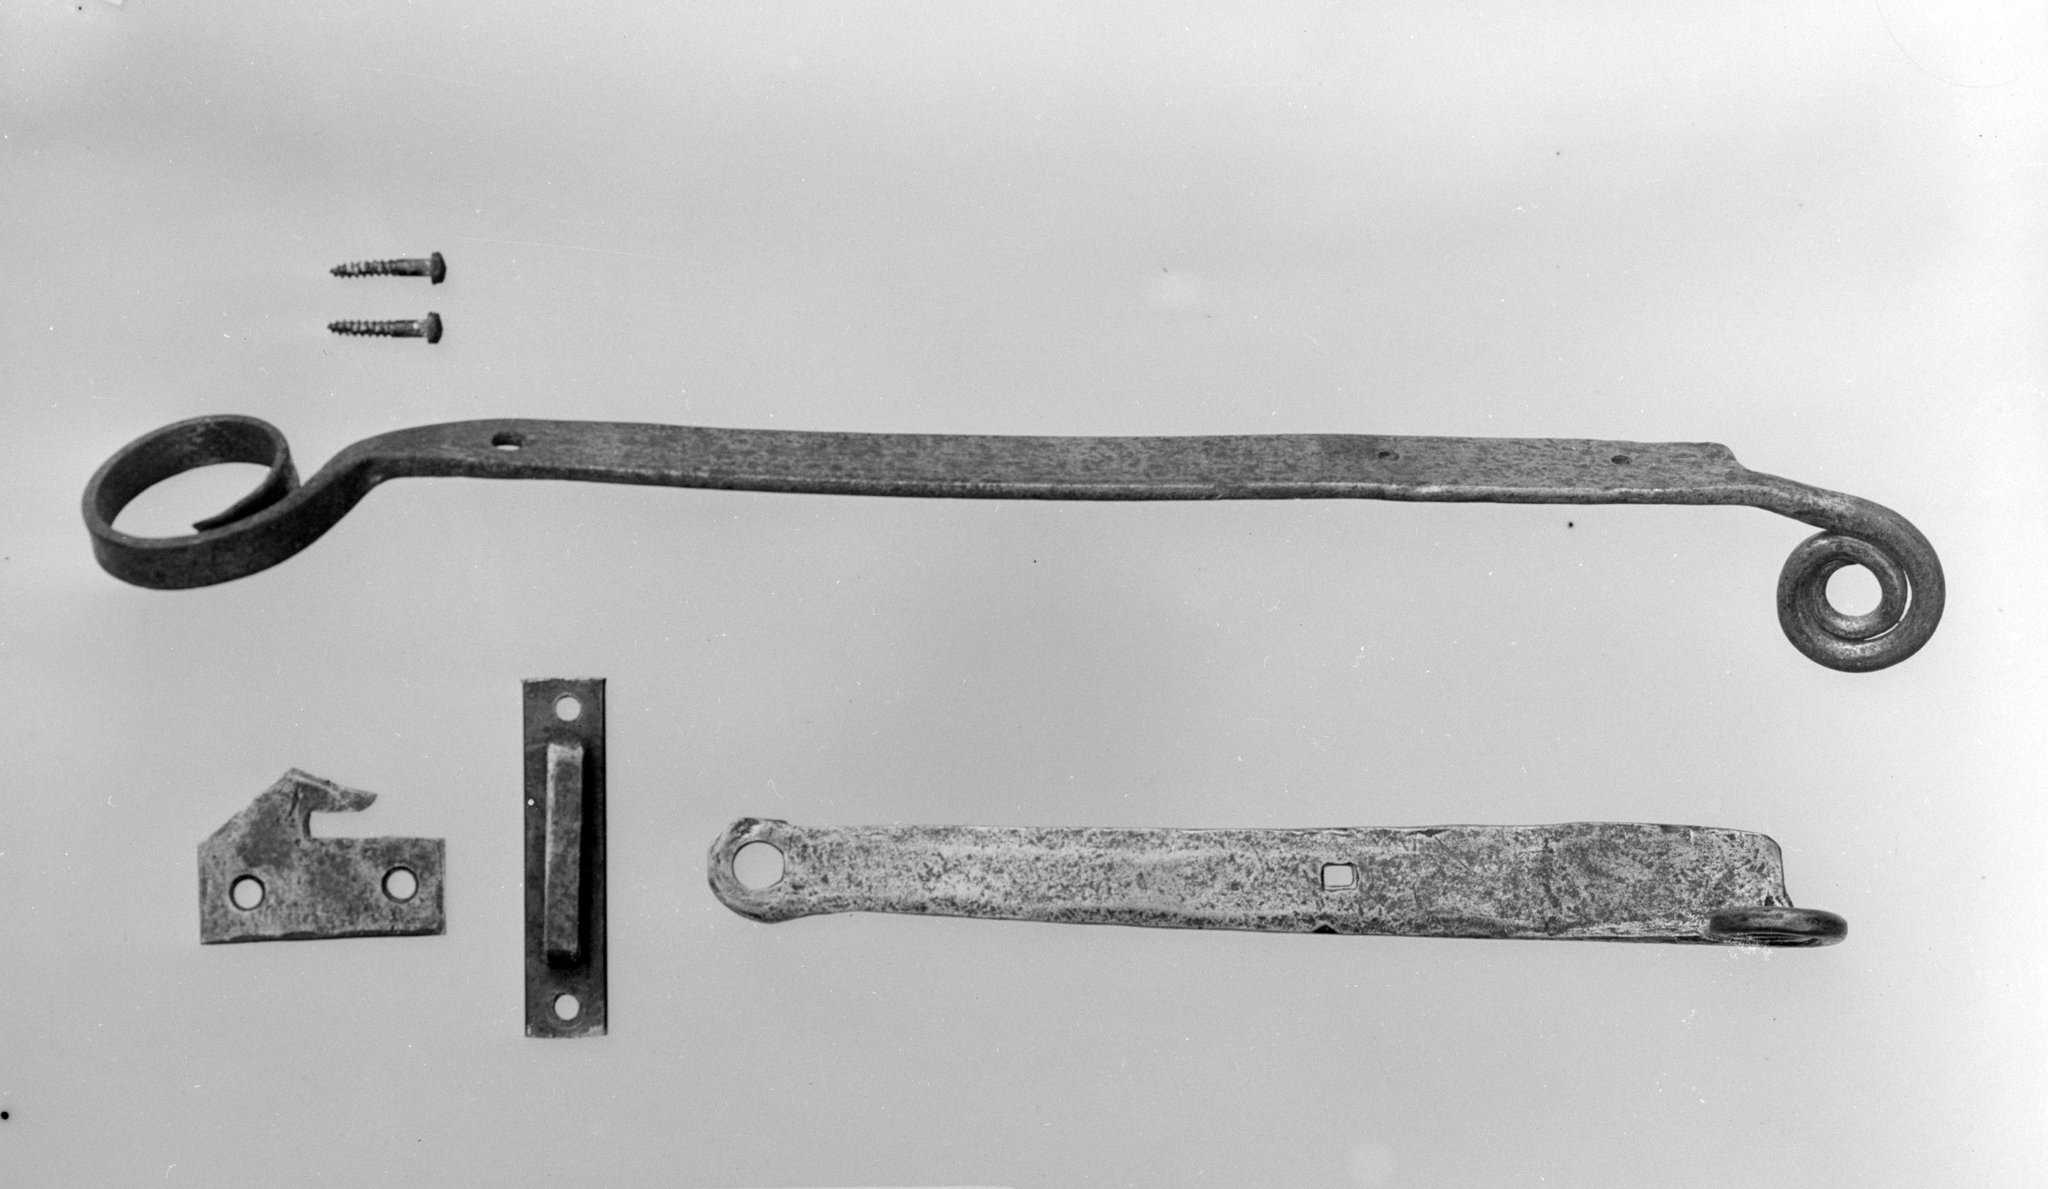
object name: latch, bar, and catch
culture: american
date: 1700-1800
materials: iron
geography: united states